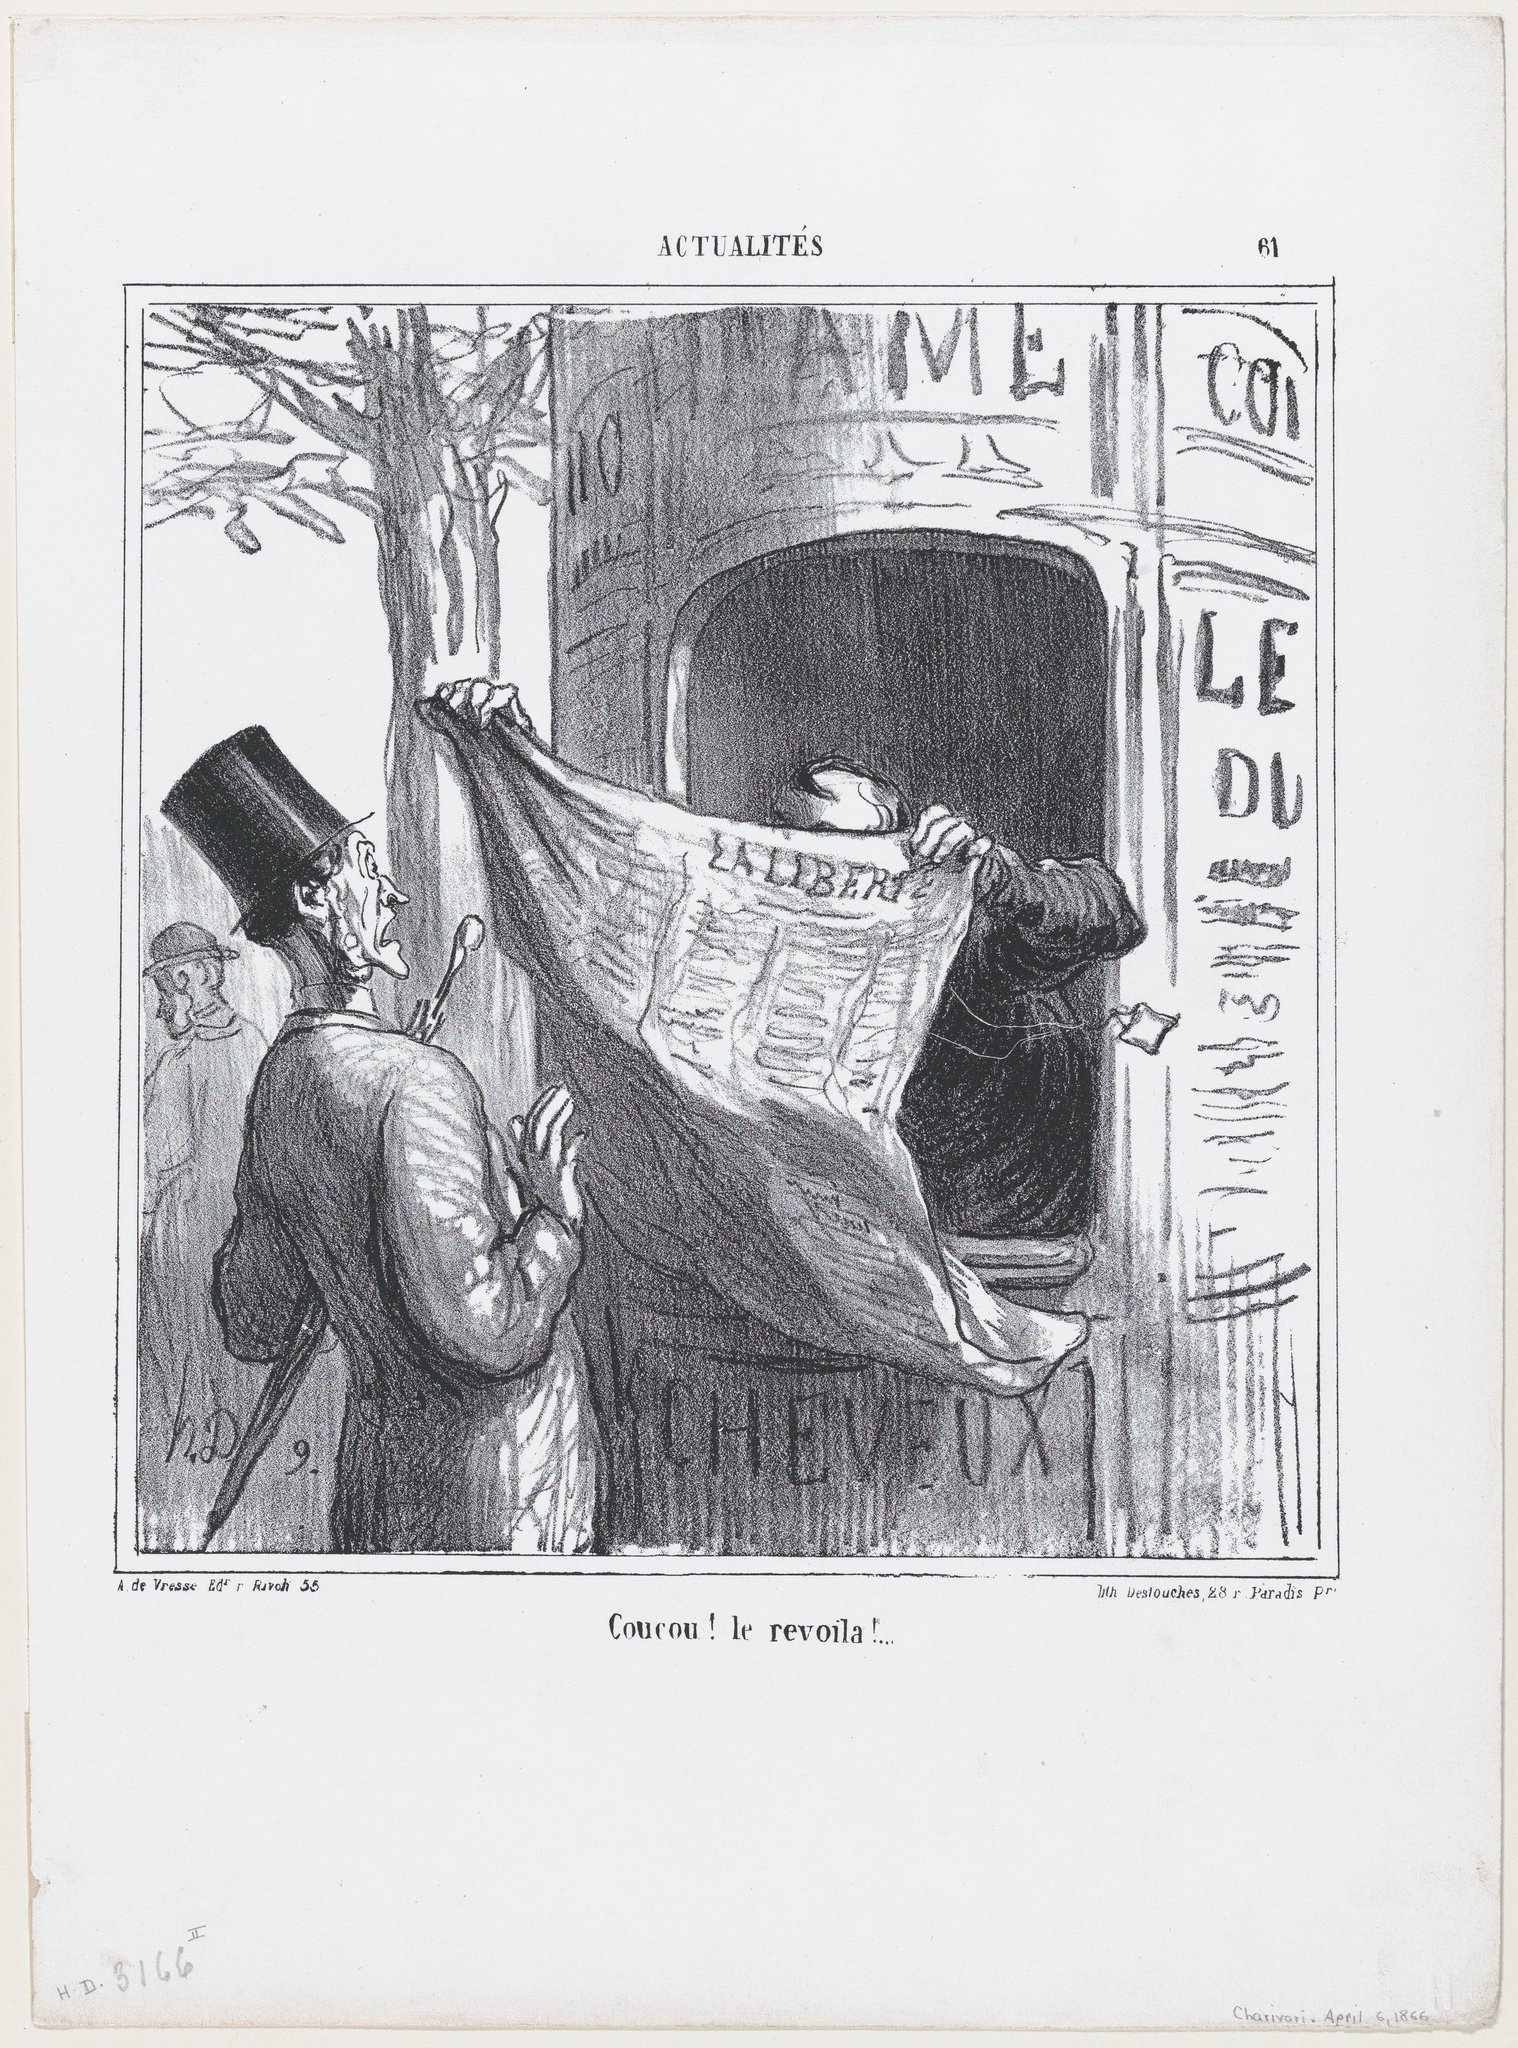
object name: print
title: Yoohoo! here it is again!, from 'News of the day,' published in "Le Charivari"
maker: honoré daumier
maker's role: artist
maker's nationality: french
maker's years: 1808-1879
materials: paper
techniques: lithograph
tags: satire,men,reading